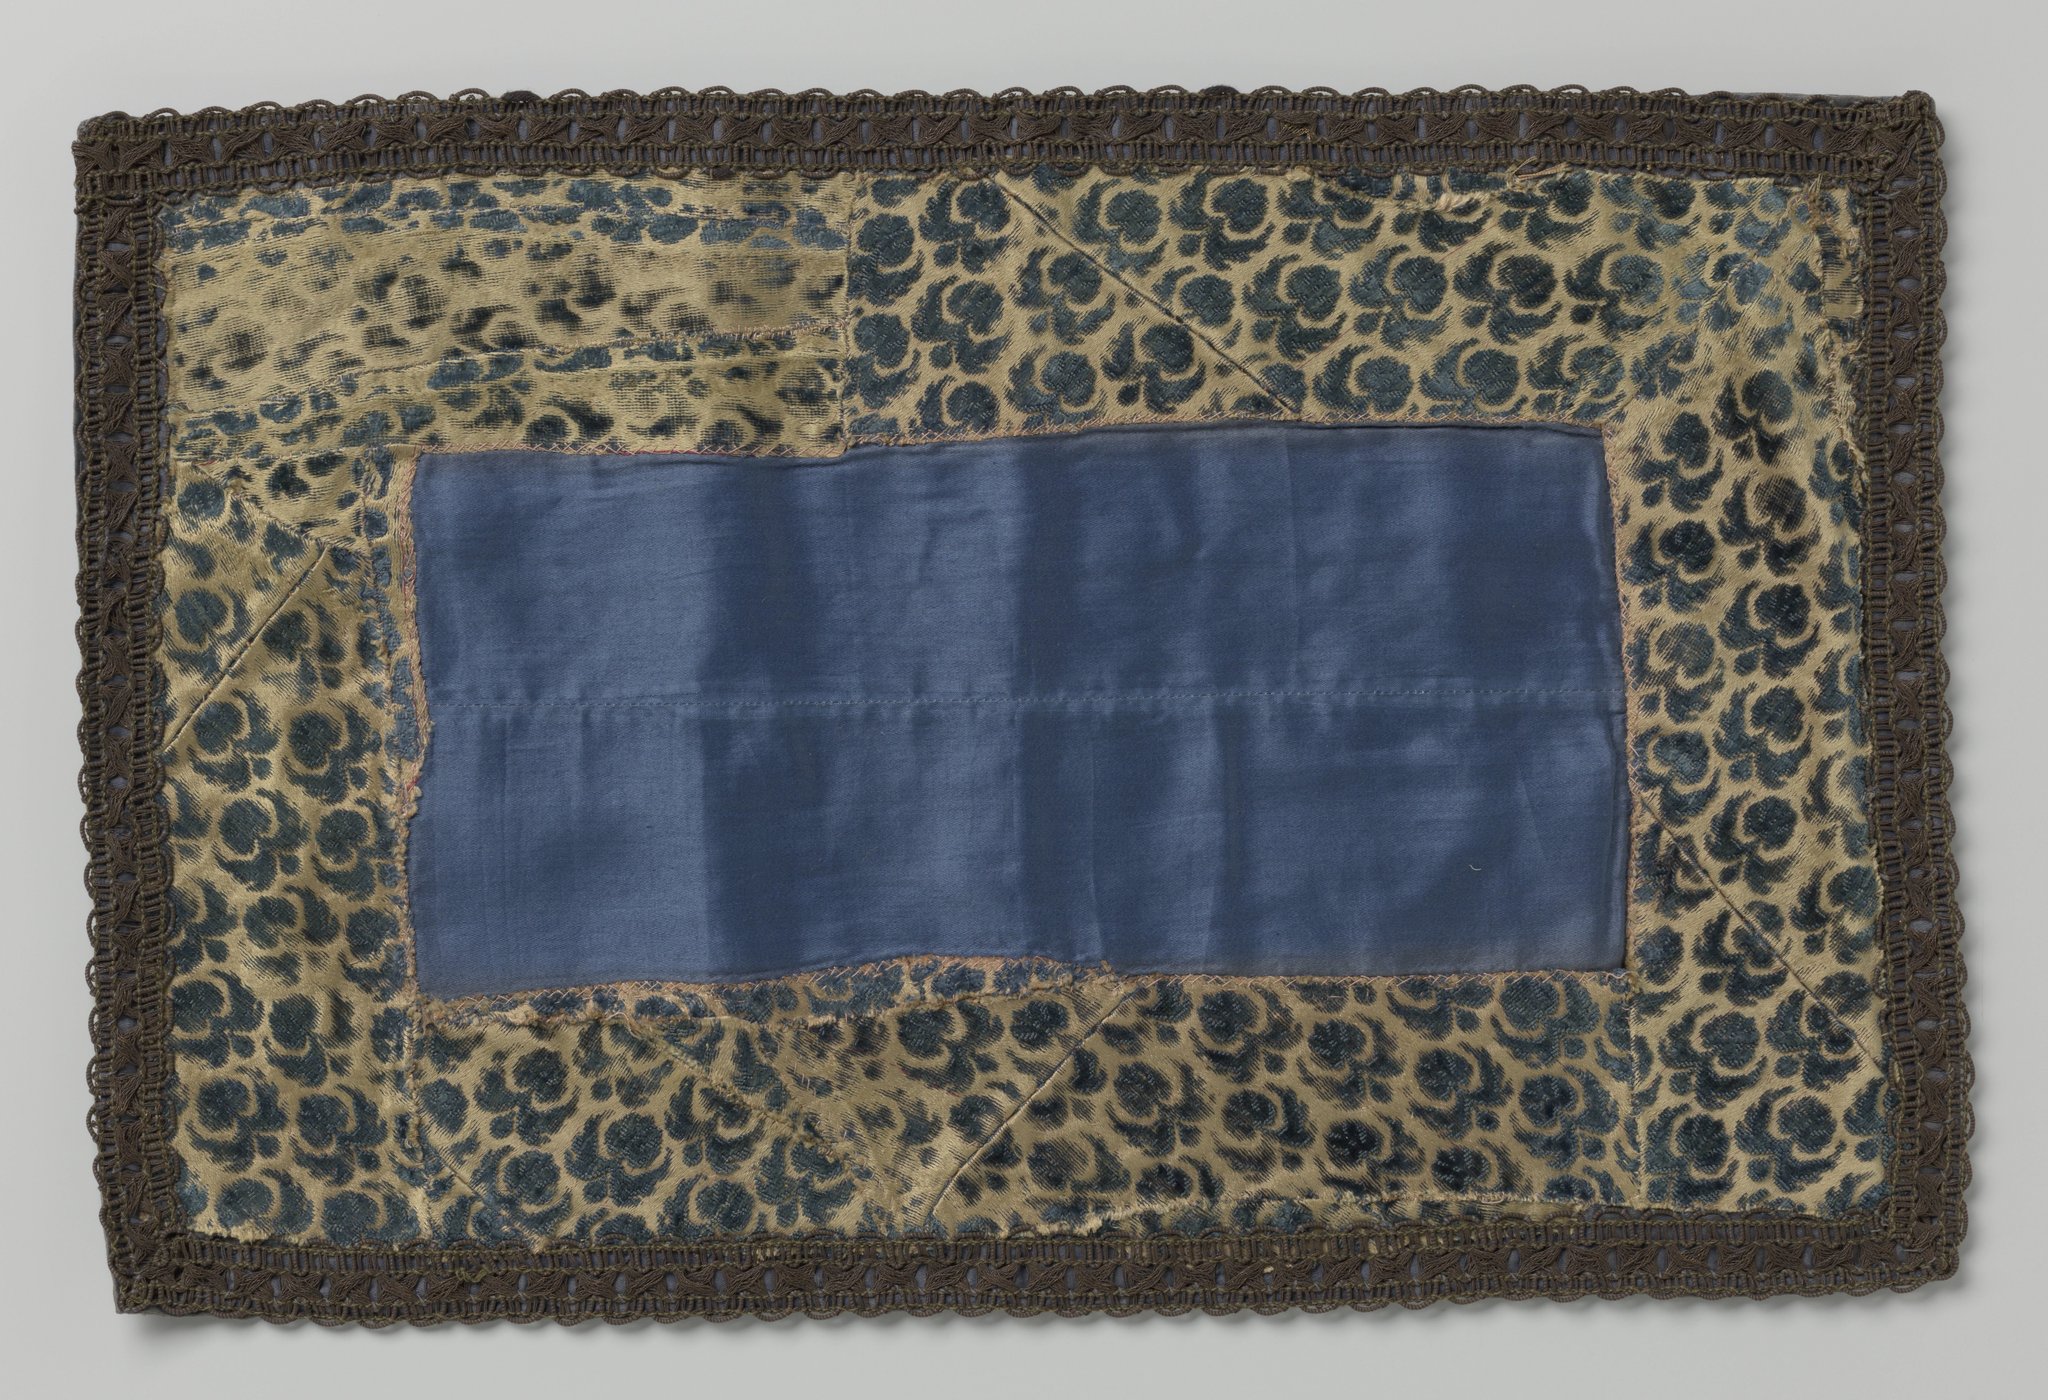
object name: kleed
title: Kleed van satijn met ciseléfluweel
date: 1500-1600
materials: ciselé velvet, cotton, textile, silk, velvet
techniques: weave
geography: italy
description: Een kleedje samengesteld uit vijftien fragmenten van zijde met een strooipatroon van blauwe palmetten op beige satijnen grond. Het midden van het kleedje, evenals de voering, is van blauw satin. Omzoomd door bruin getinte goud galon. Opmerking: Bestaat uit galon: 2.3 cm, rand fluweel 15 fragmenten, satin (midden veld). Zijdefluweel identiek aan de zijdefluweel BK-15368.